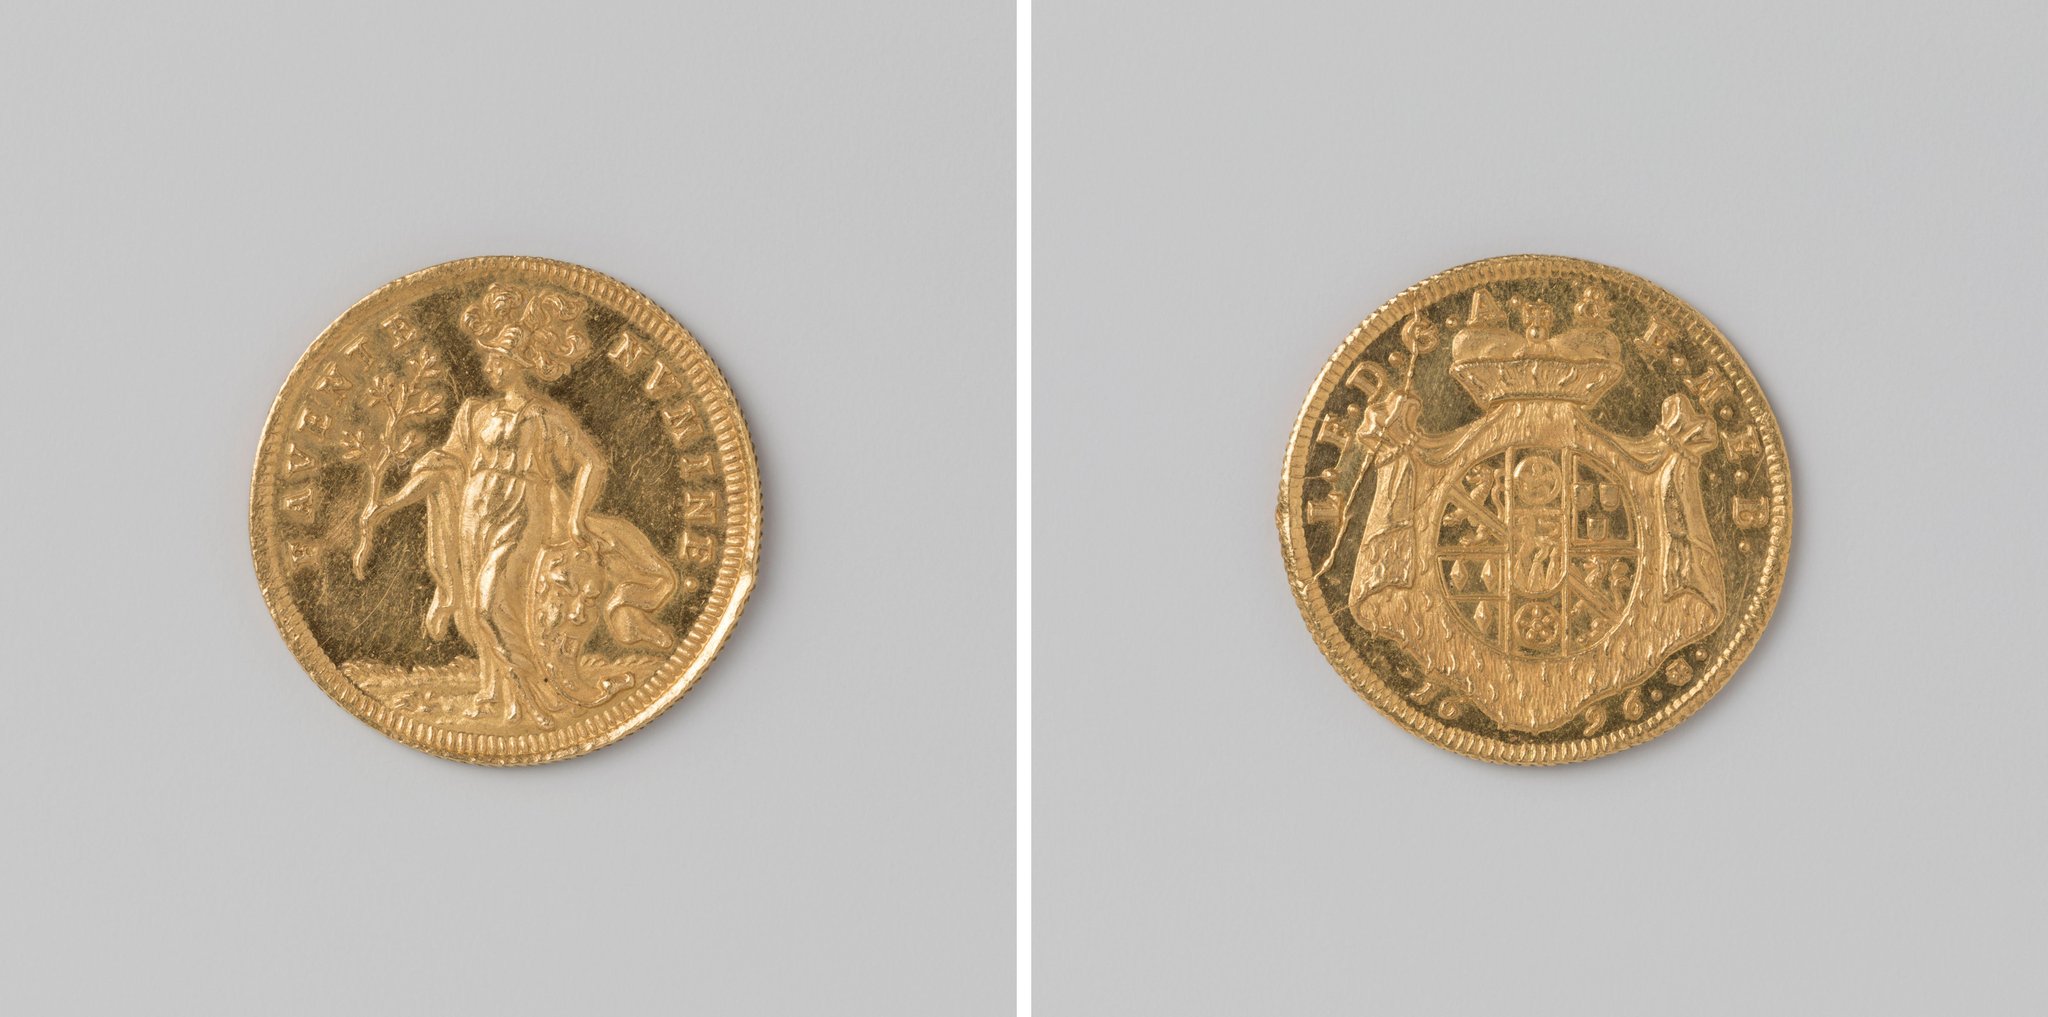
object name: ducat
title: Lothar Franz van Schonborn, aartsbisschop van Mainz en bisschop van Bamberg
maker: Anonymous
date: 1696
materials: gold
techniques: striking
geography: germany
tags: earl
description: Voorzijde: vrouwefiguur met olijftak en schild binnen omschrift. Keerzijde: wapenschild binnen omschrift